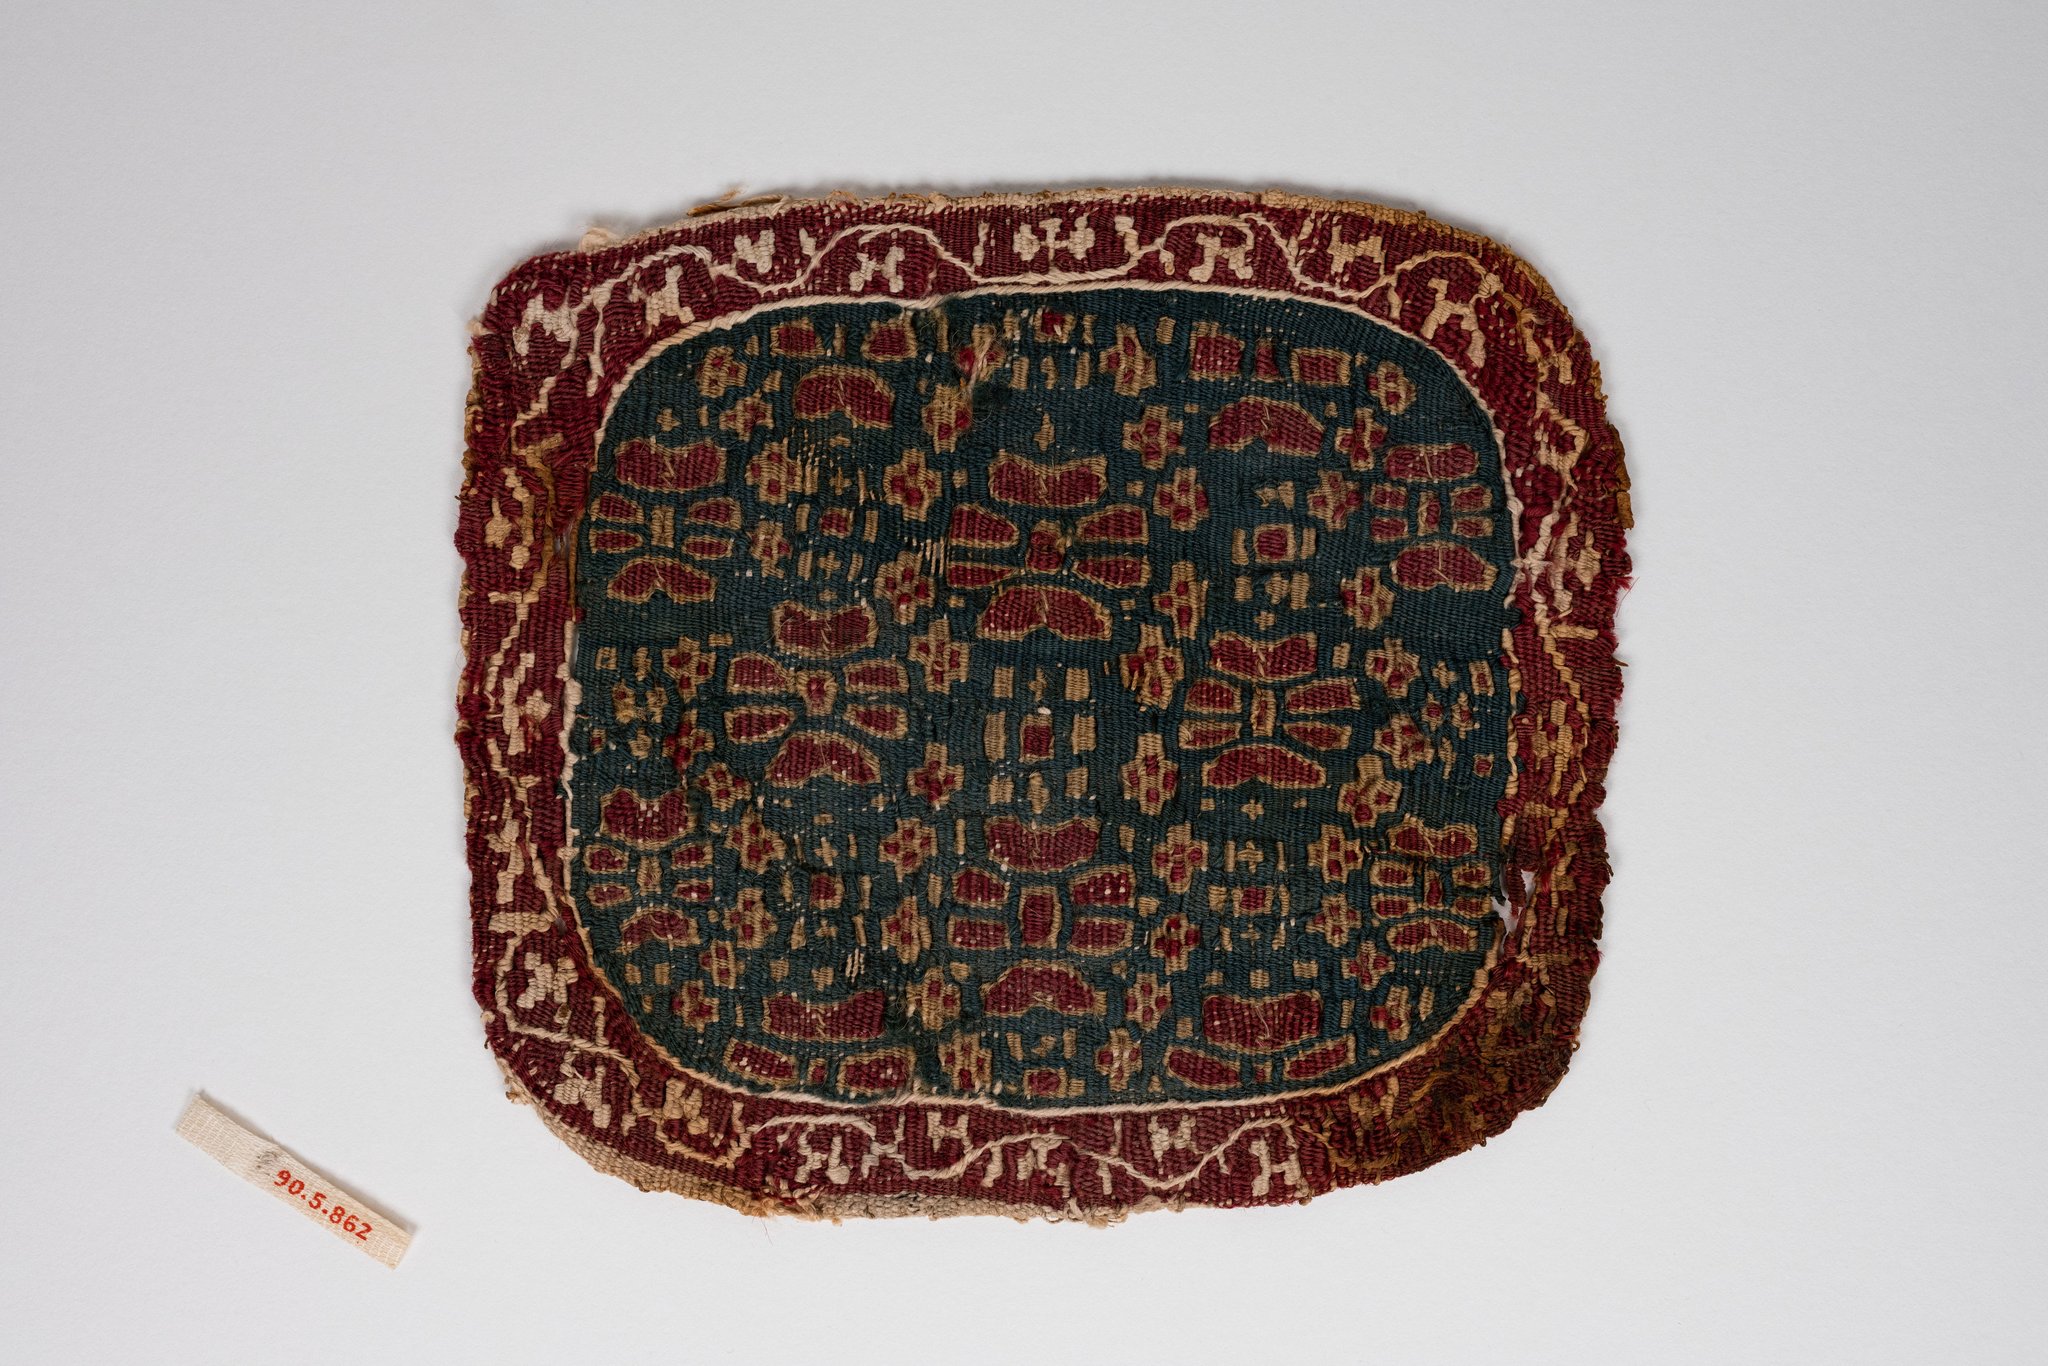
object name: panel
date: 501-700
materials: wool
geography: egypt